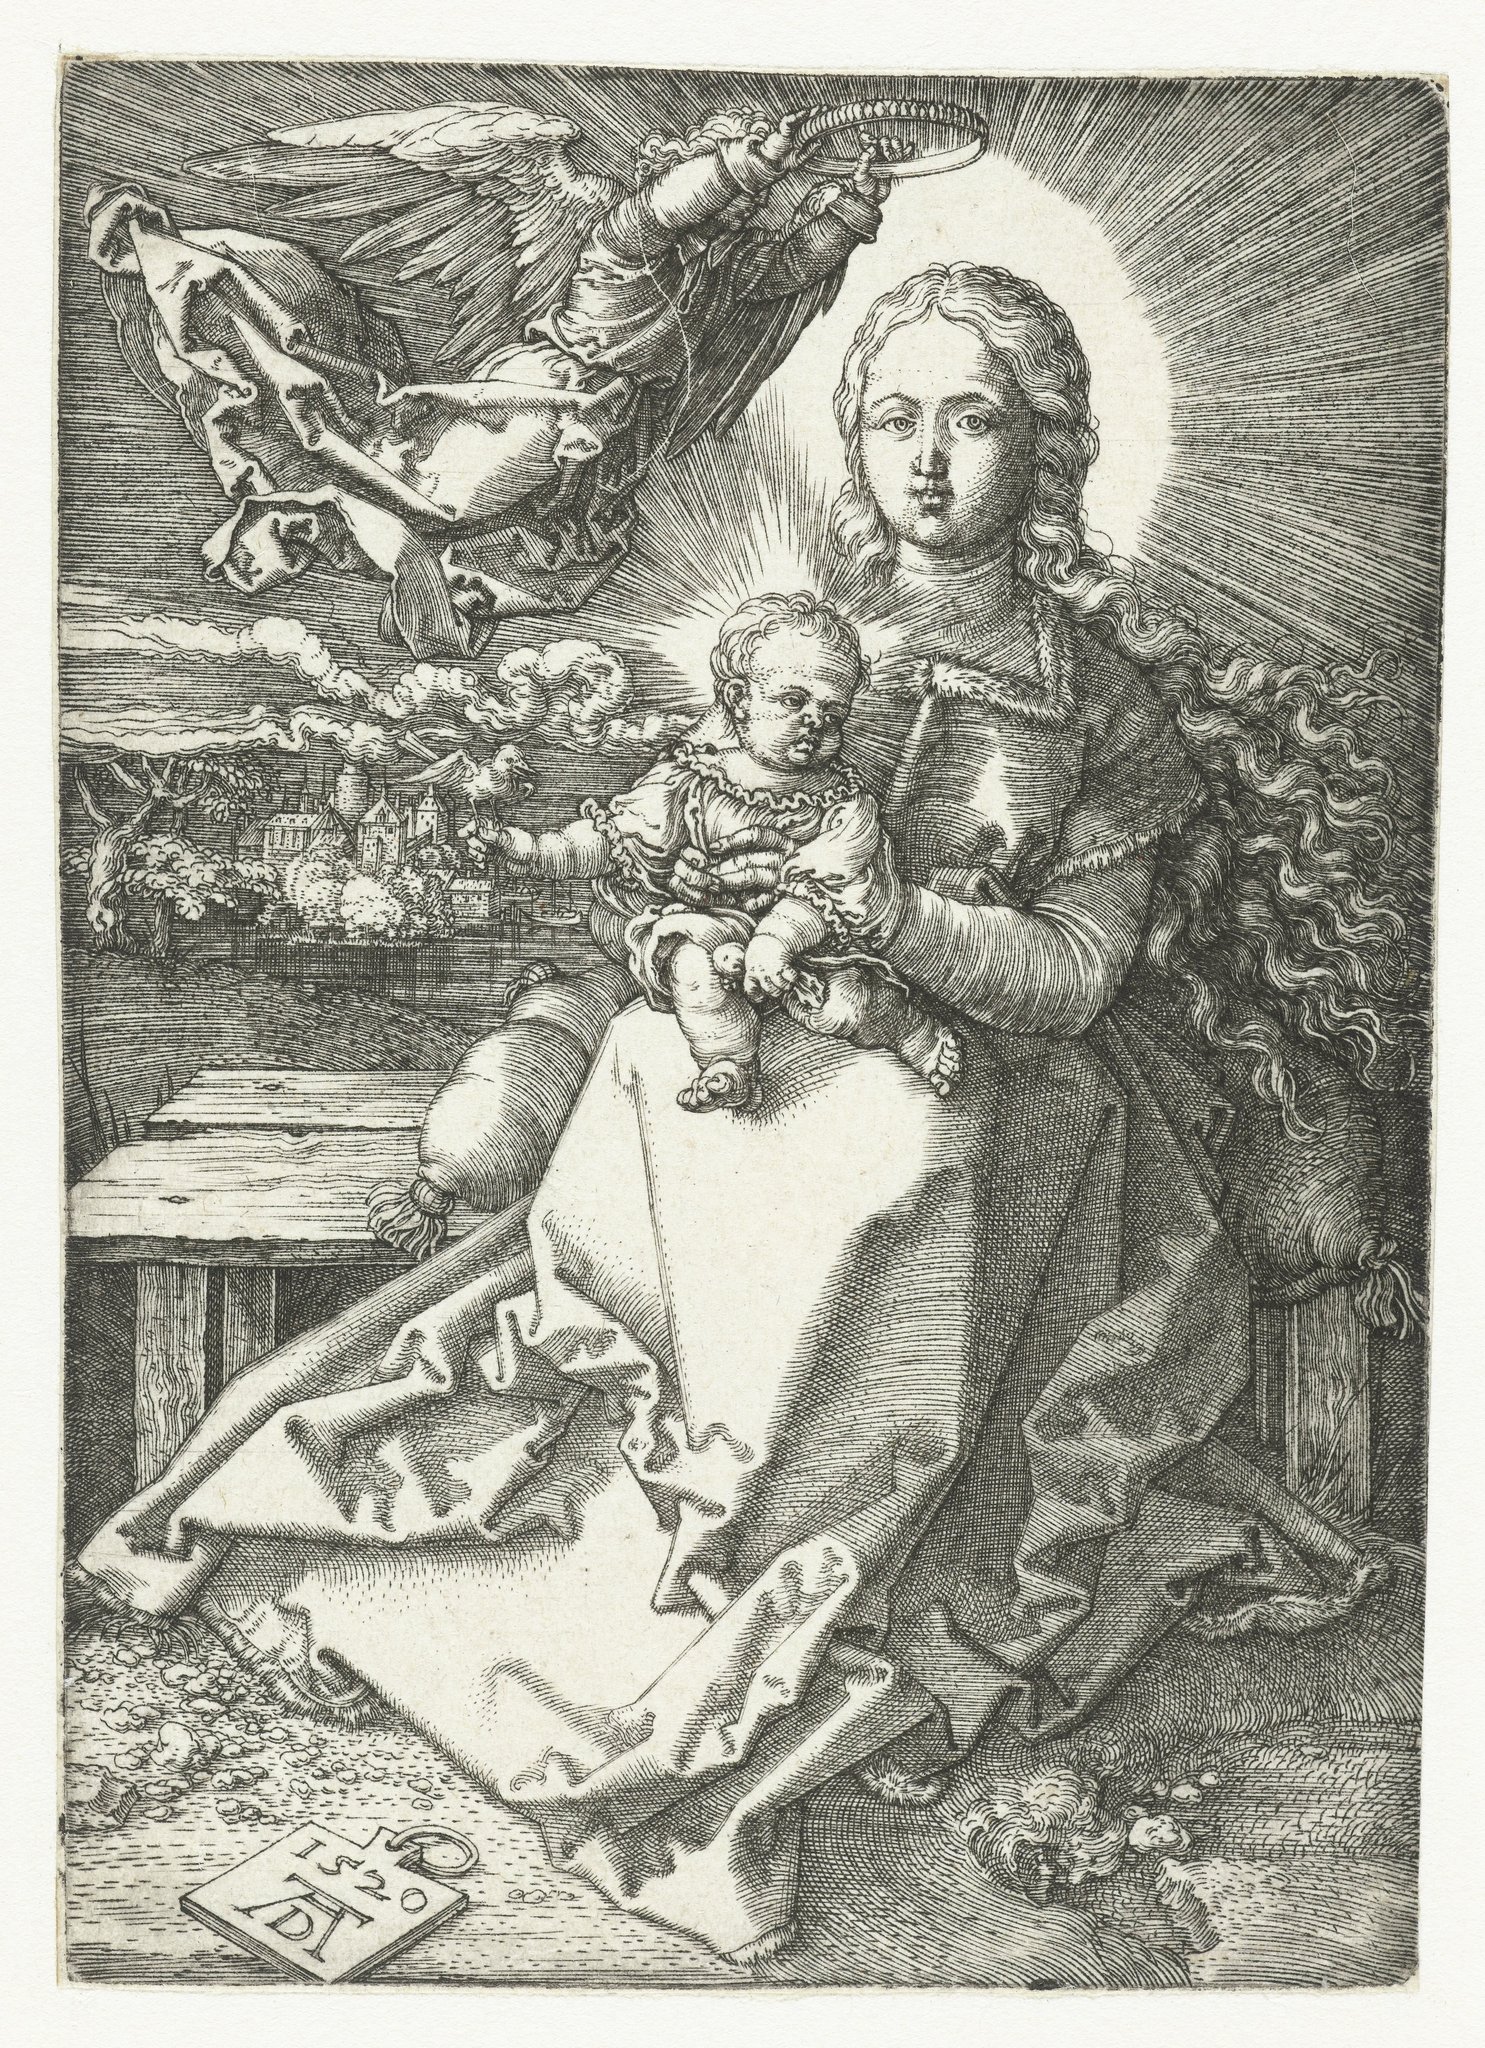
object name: print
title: Maria met kind gekroond door een engel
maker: albrecht dürer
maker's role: draughtsman, painter, print maker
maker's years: 1471-1528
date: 1520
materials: paper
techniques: engraving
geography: nuremberg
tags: angels crowning and/or bringing palm-branches, mary sitting or enthroned, the christ-child in front of her, sitting in her lap (or in front of her bosom)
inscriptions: collector's mark: Lugt 240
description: Maria zit op een bankje met het Christuskind op schoot. Een engel houdt een kroon boven haar hoofd. Links op de achtergrond een stad of groot gebouw.